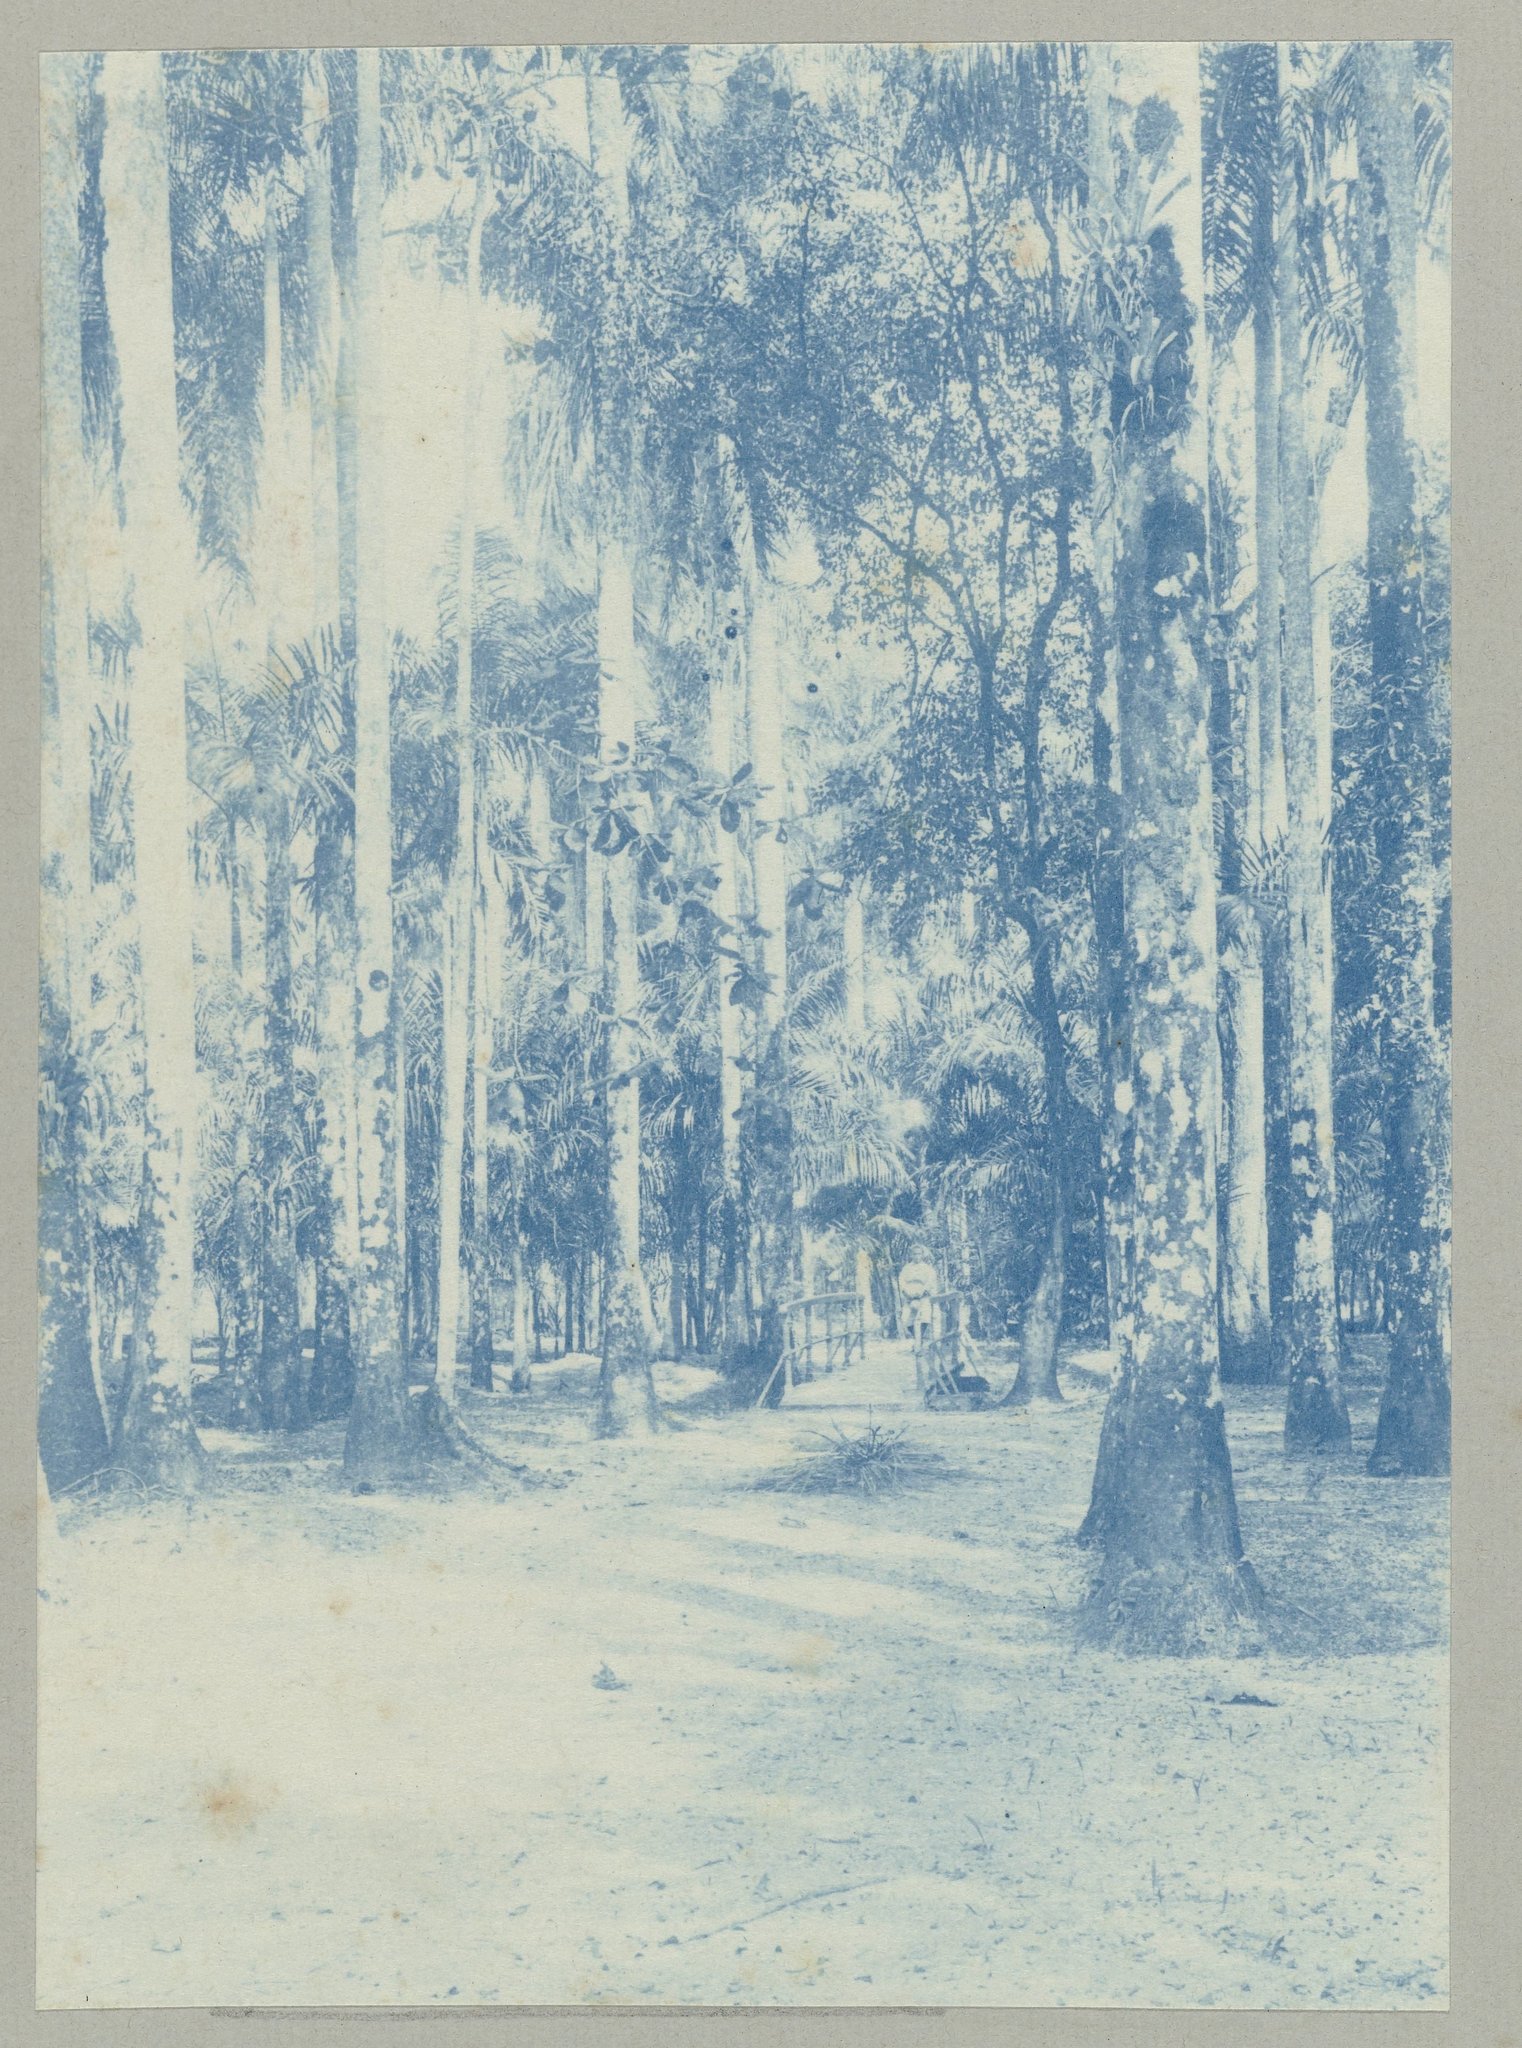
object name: photograph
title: Palmentuin, Paramaribo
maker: hendrik doijer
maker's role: engineer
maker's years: 1863-1925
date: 1903-1910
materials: photographic support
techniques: cyanotype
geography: suriname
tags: suriname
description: Hoge bomen in de Palmentuin te Paramaribo, aan het eind een bruggetje waarop een jongen staat. Onderdeel van het fotoalbum Souvenir de Voyage (deel 2), over het leven van de familie Doijer in en rond de plantage Ma Retraite in Suriname in de jaren 1903-1910.